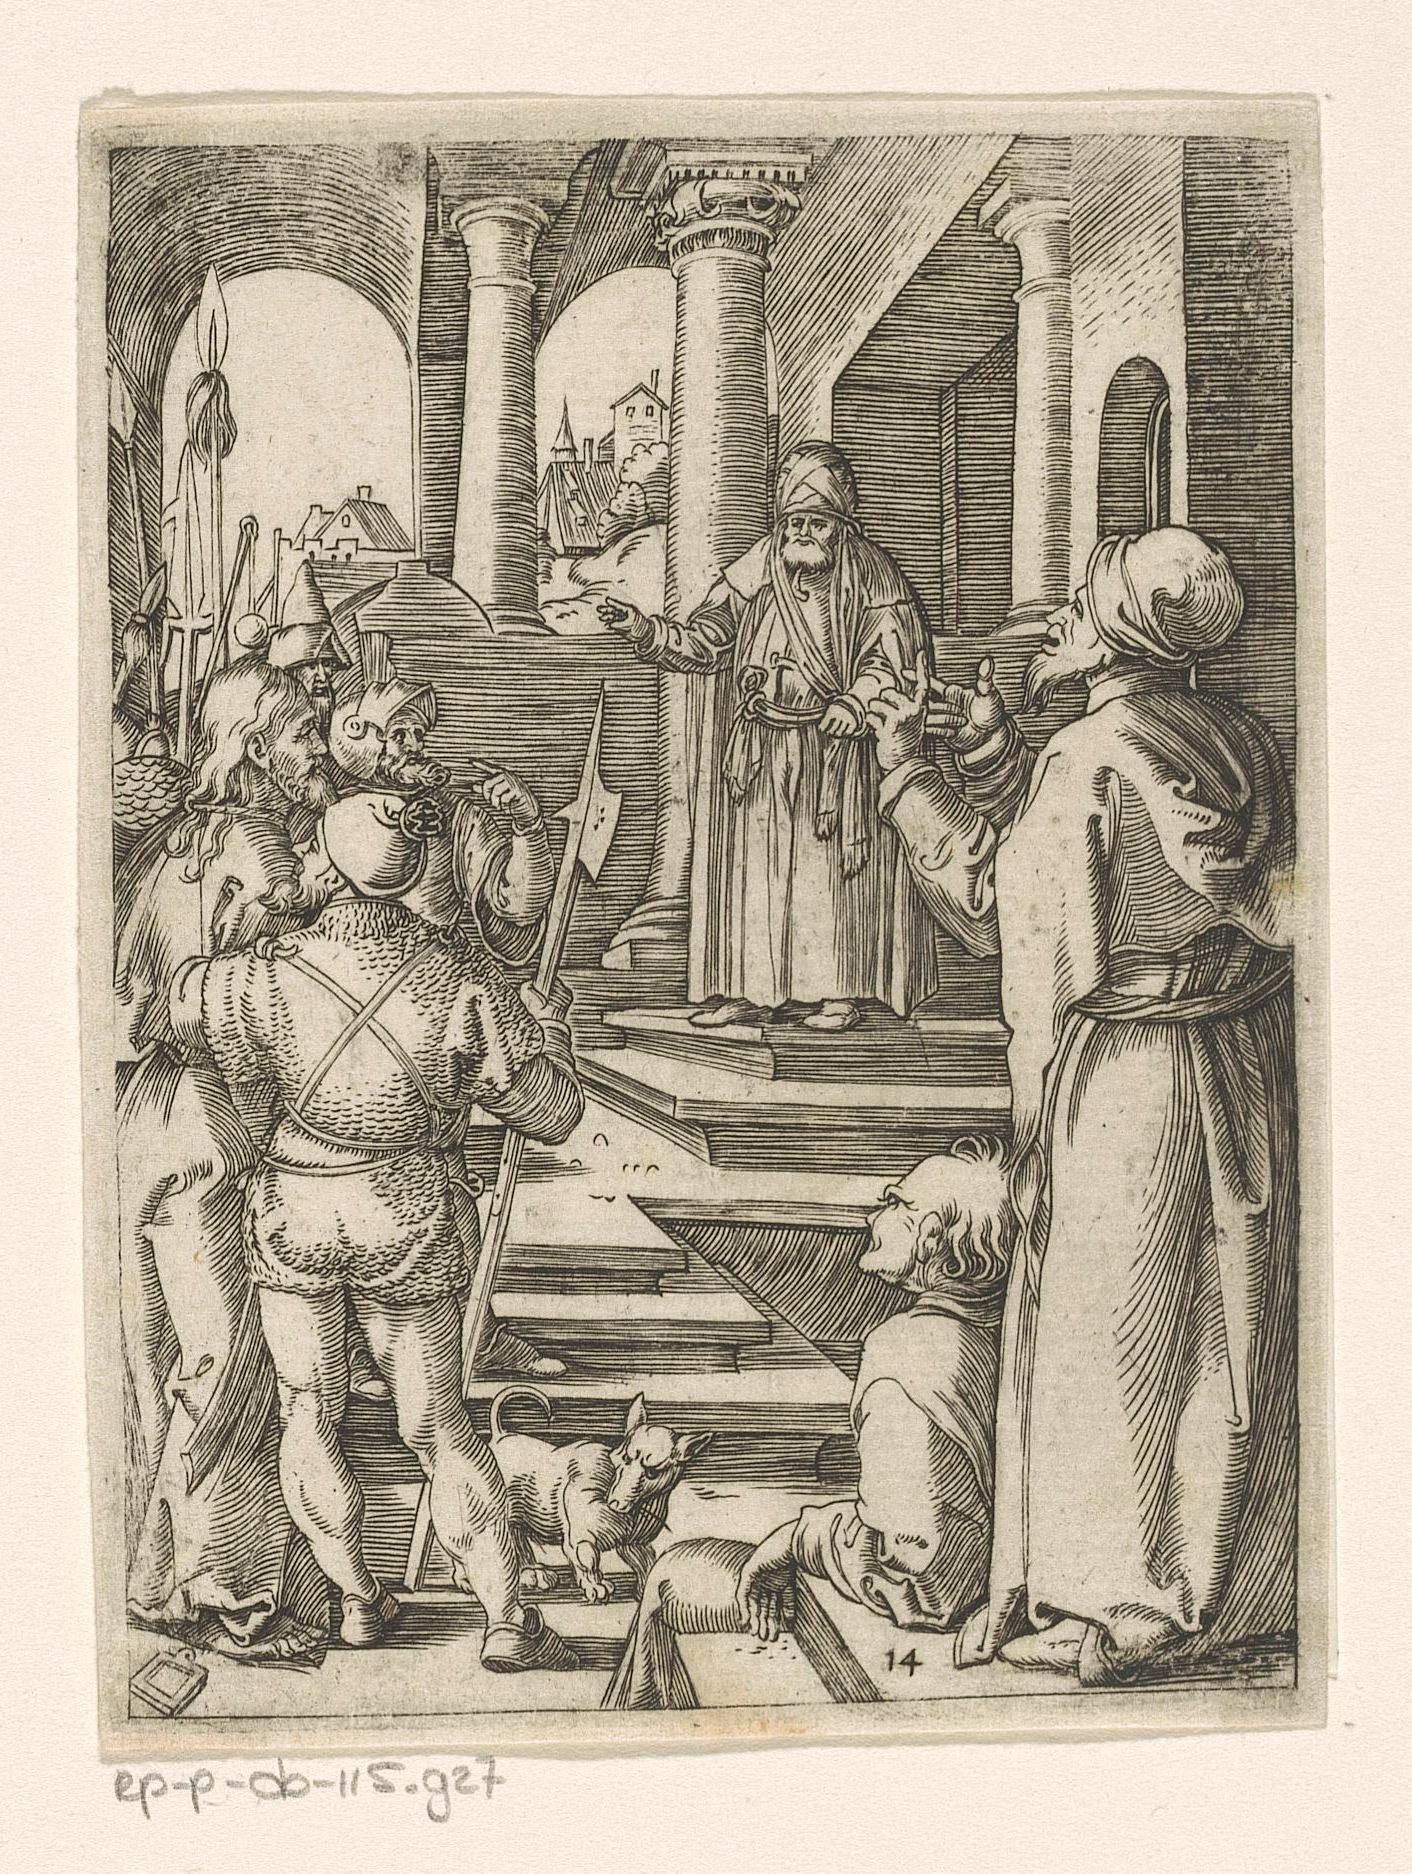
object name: print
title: Passie van Christus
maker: marcantonio raimondi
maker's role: print maker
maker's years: 1470-1534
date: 1511-1534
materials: paper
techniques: engraving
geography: germany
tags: christ before pontius pilate (matthew 27:11-26; mark 15:2-15; luke 23:2-7, 23:13-25; john 18:28 - 19:16), pilate in debate with the jews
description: Prent naar houtsnede van Albrecht Dürer uit een serie van zevenendertig prenten met als onderwerp het levensverhaal van Christus, bekend als Passie van Christus.